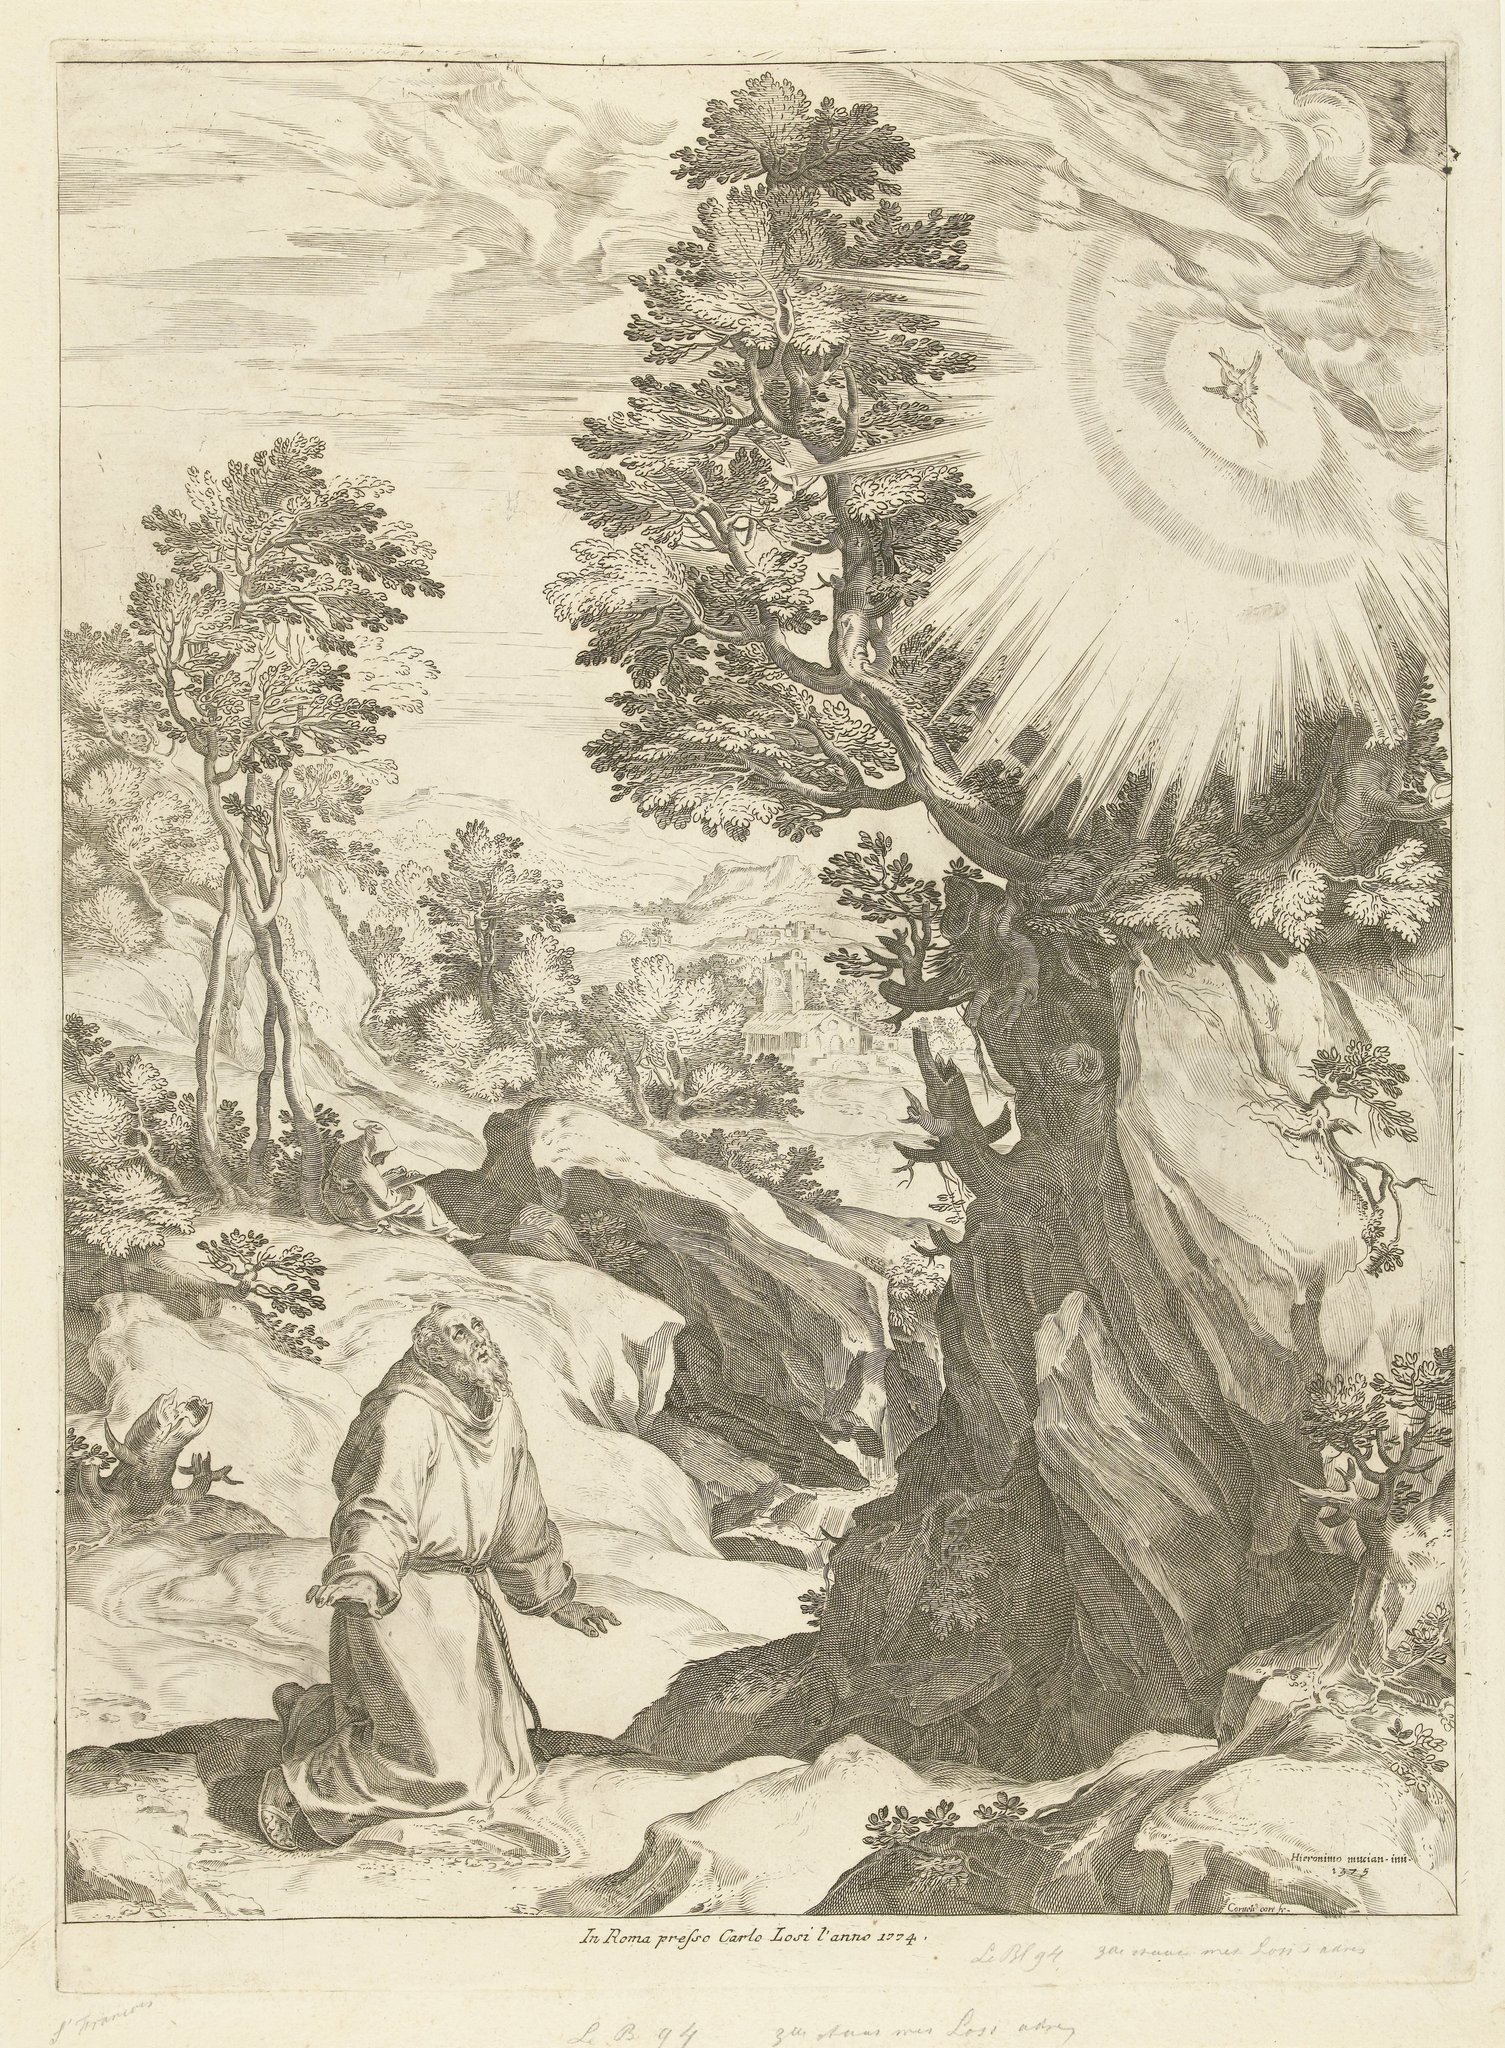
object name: print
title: Landschap met visioen van de H. Franciscus van Assisi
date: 1575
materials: paper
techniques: engraving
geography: rome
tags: martyrdom, suffering, misfortune, death of st. francis of assisi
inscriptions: collector's mark: Lugt 2228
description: Op de Monte Alverna heeft Franciscus een visioen van een serafijn met zes vleugels. Franciscus gekleed in een eenvoudige monnikspij knielt neer en kijkt naar de serafijn. Op de achtergrond een landschap met de San Damianokerk in Assisi.